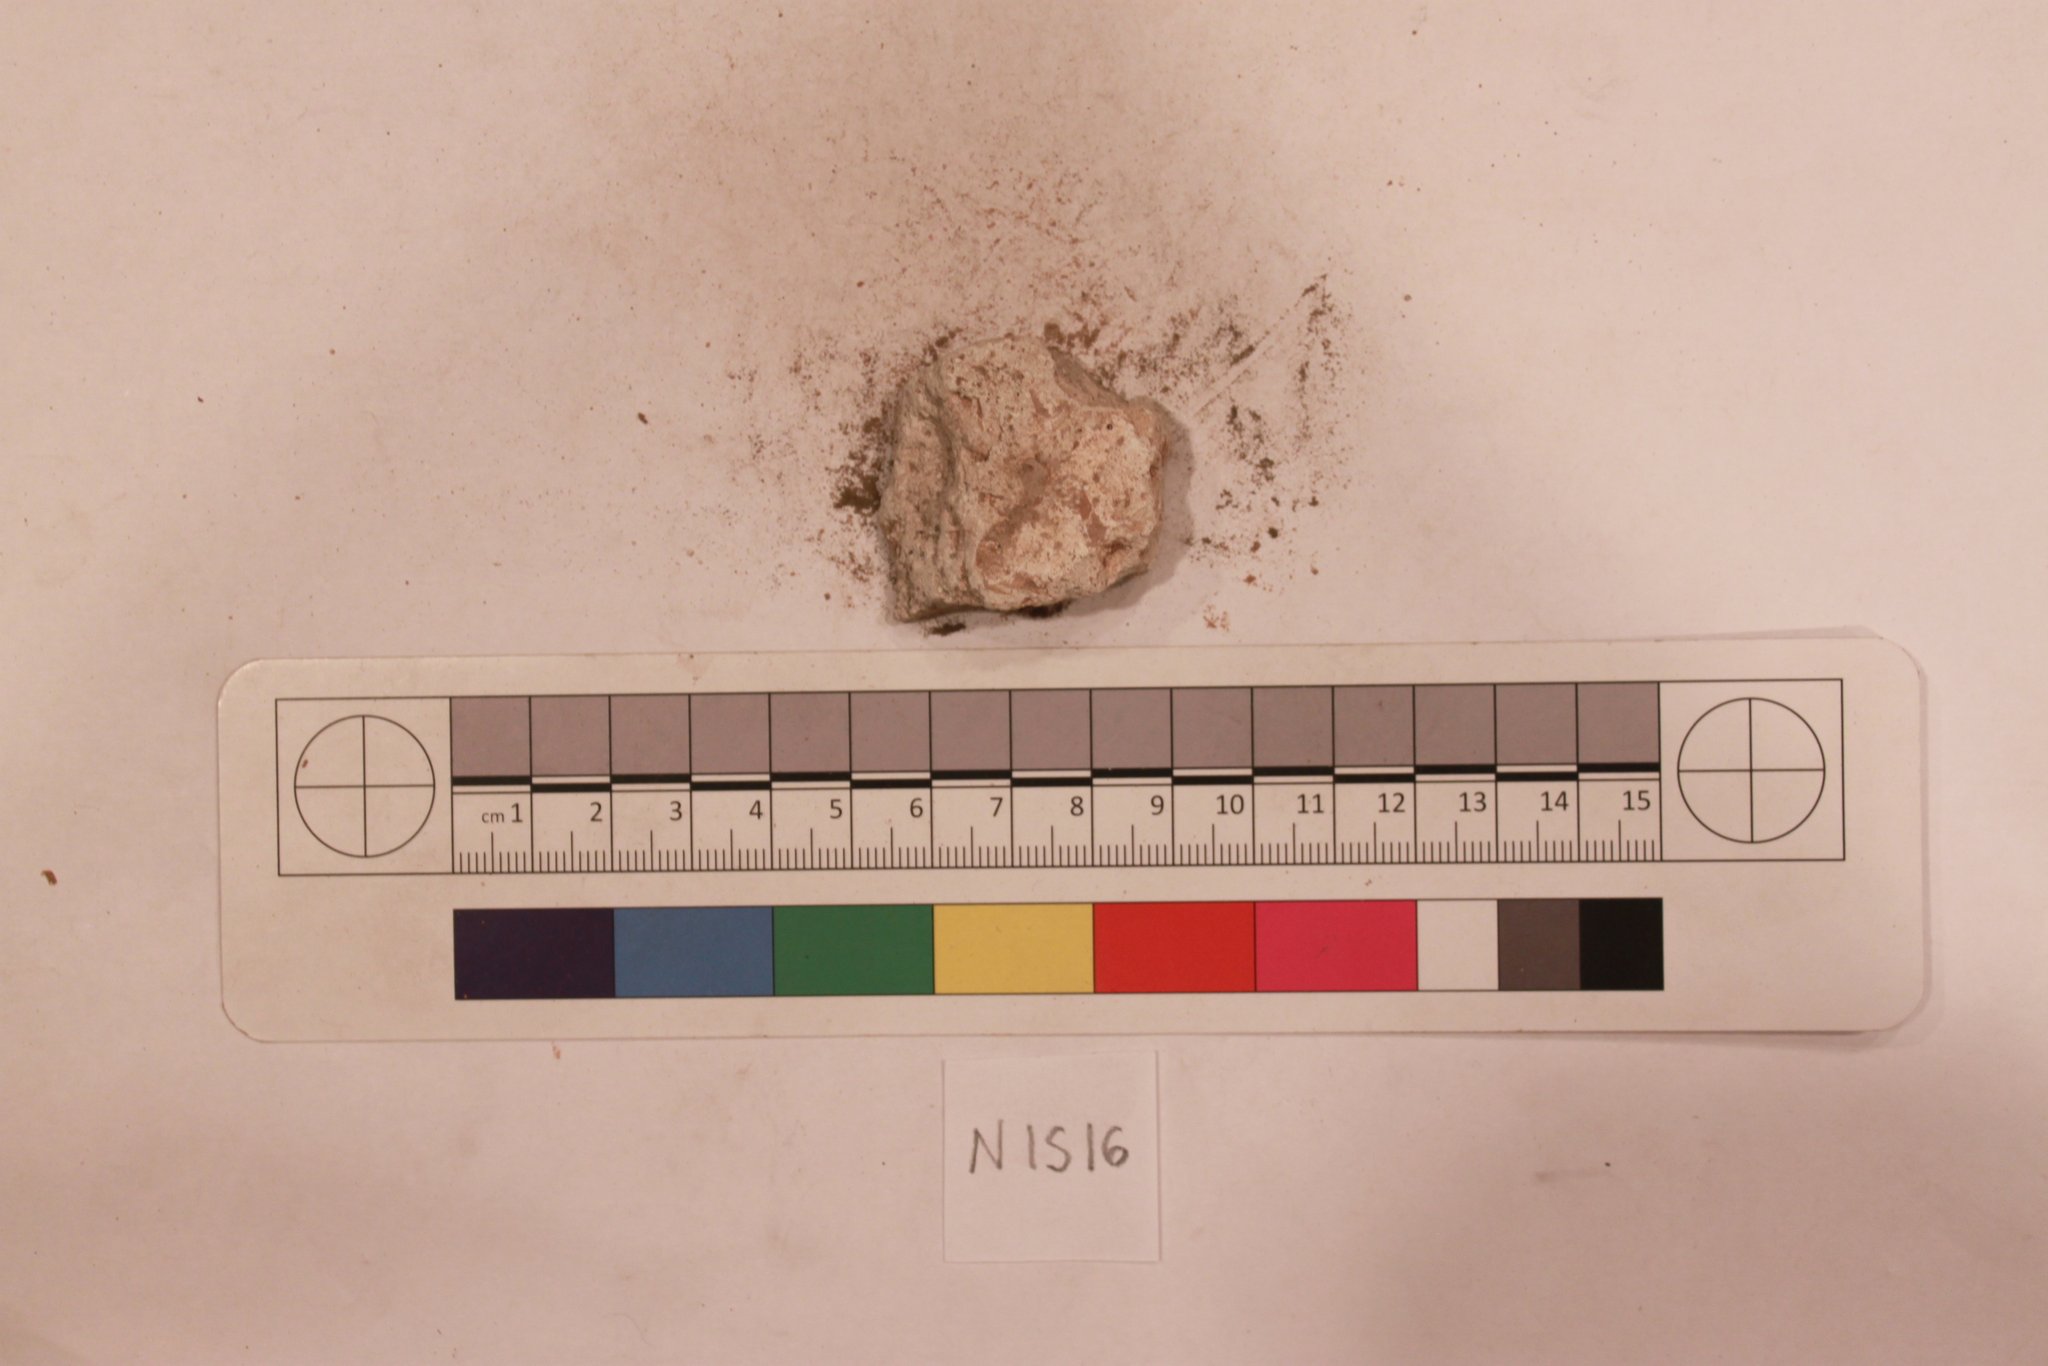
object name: fragment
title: Stucco Fragment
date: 701-1200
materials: plaster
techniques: carving, painting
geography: iran